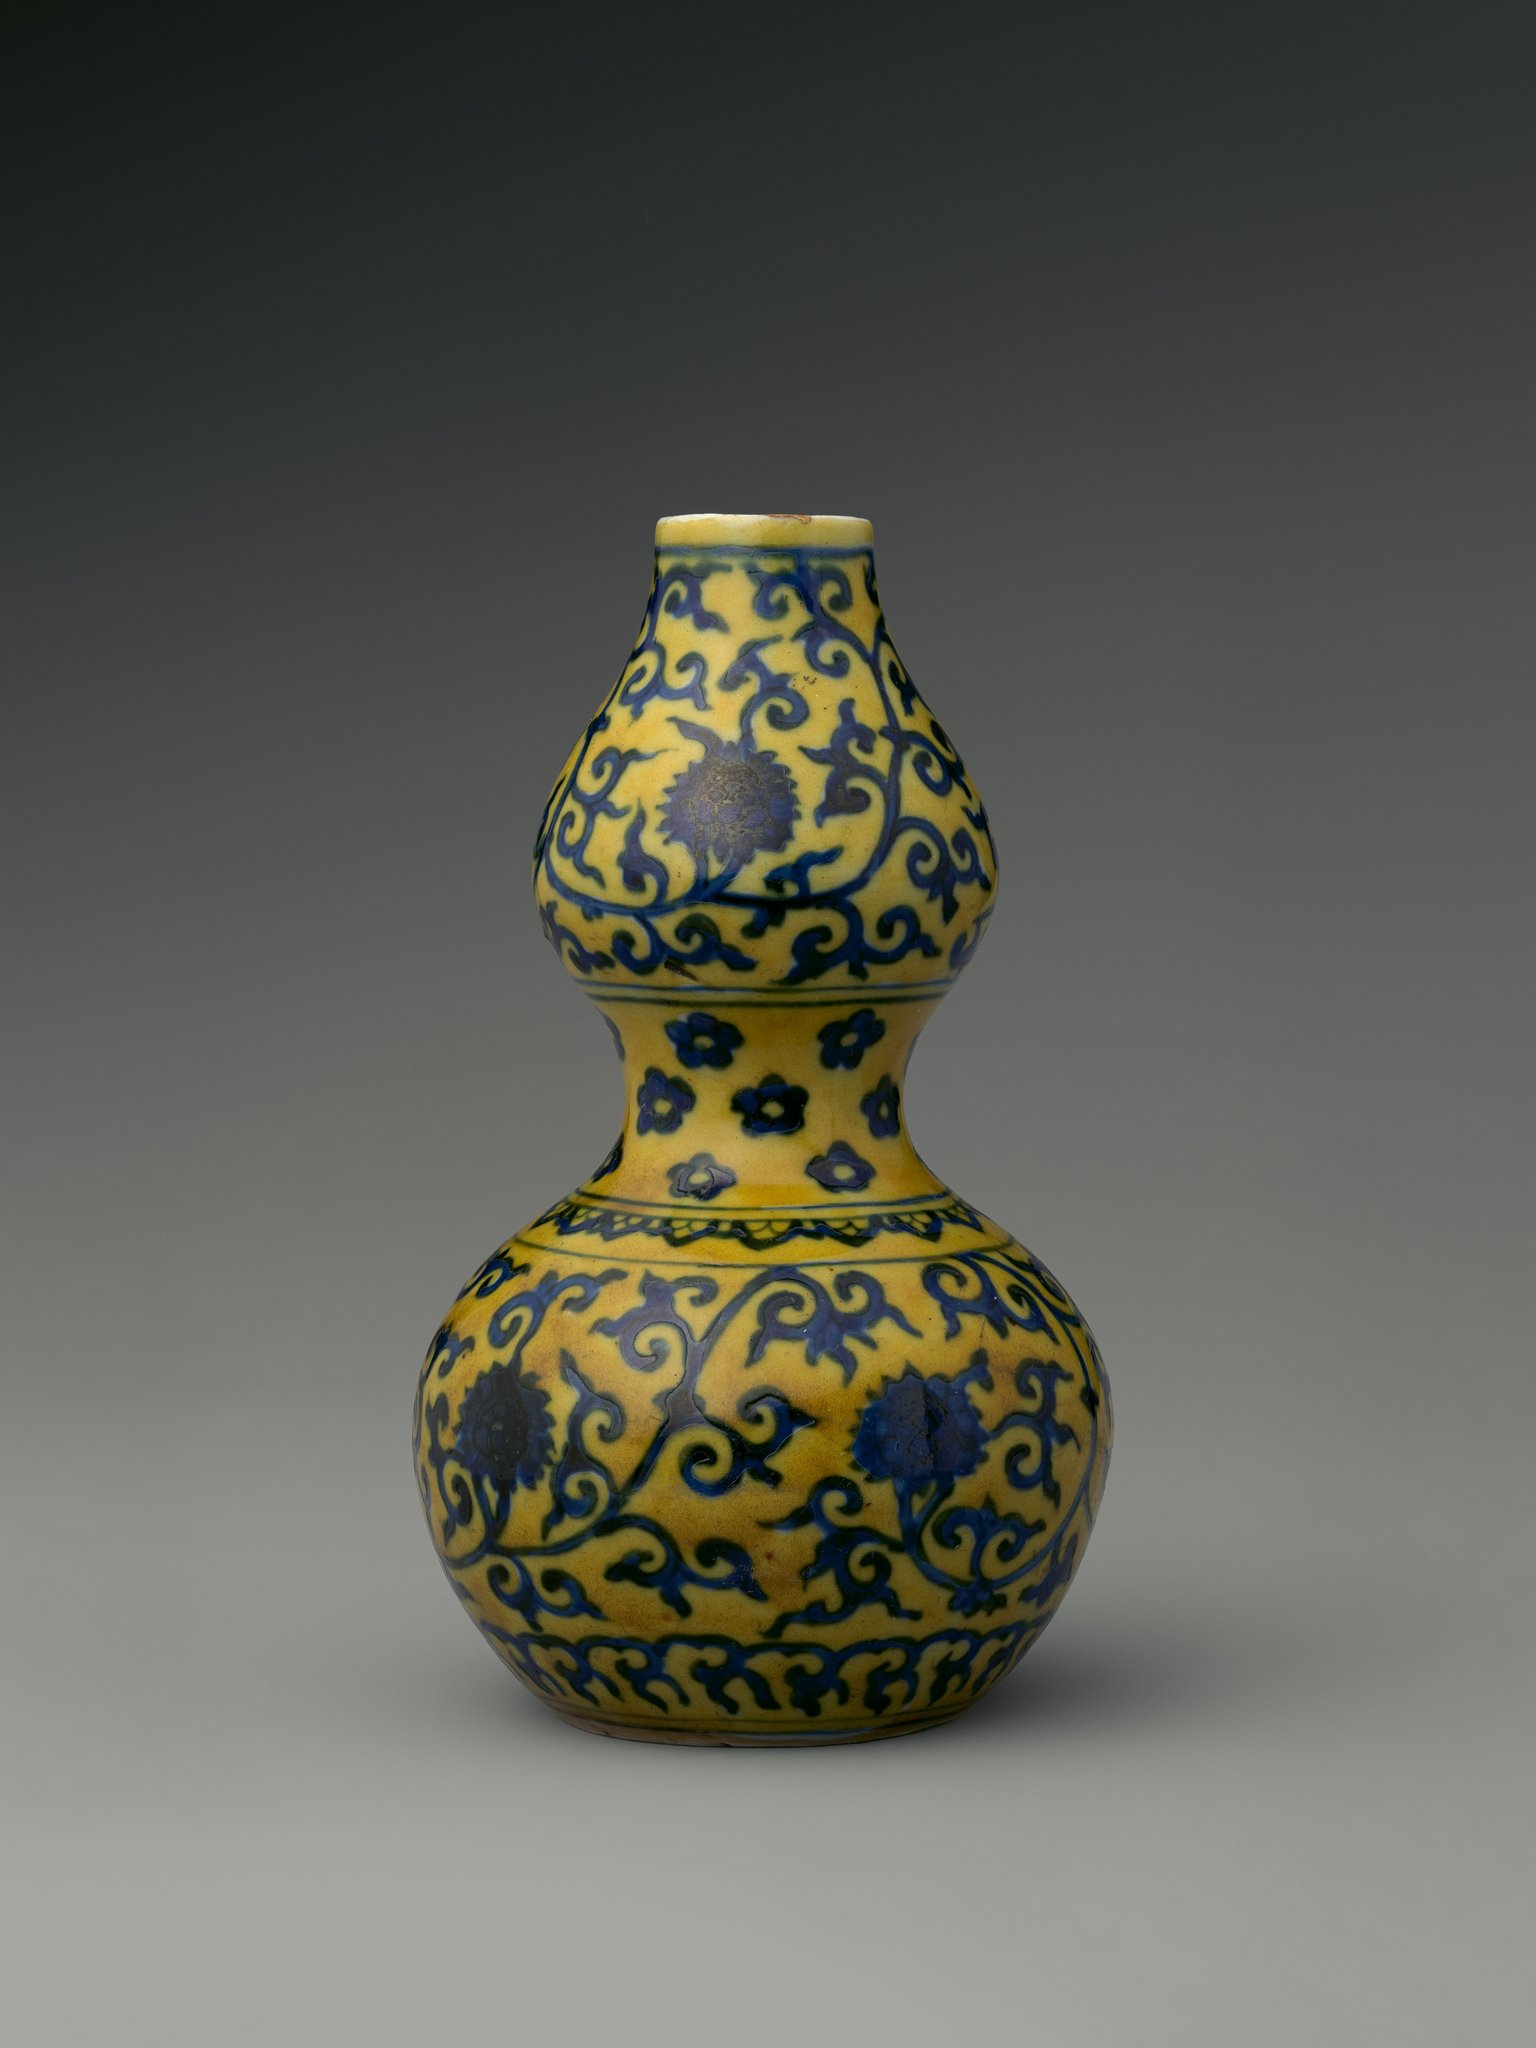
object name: bottle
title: Gourd-Shaped Bottle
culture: chinese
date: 1534-1566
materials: porcelain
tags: lotuses